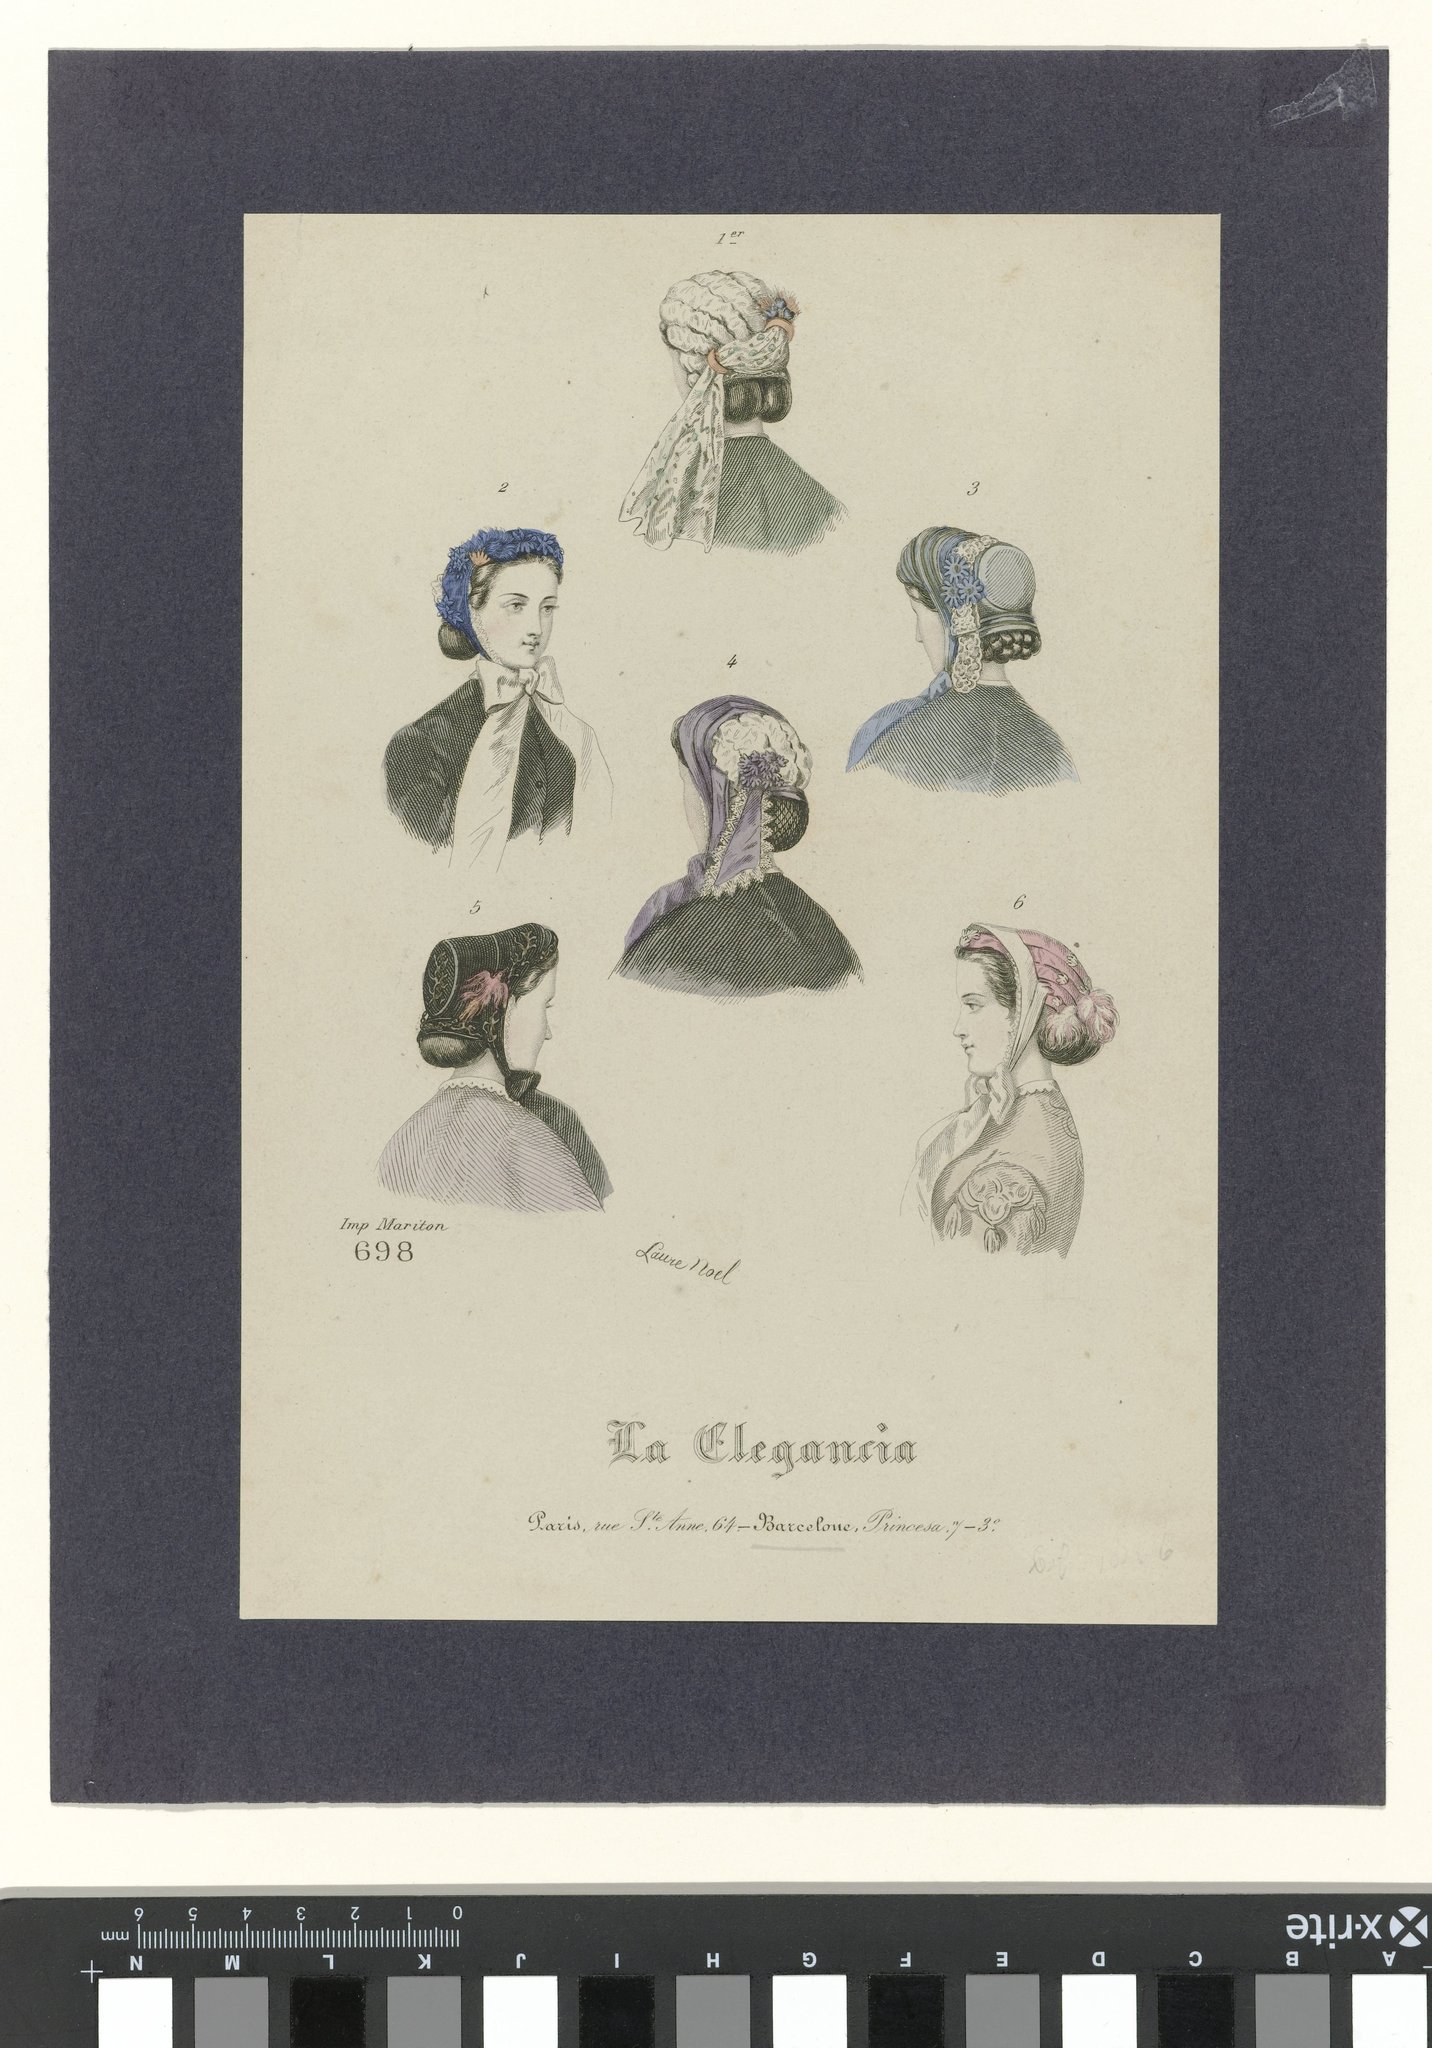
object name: fashion print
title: La Elegancia, 1854, No. 698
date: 1854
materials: paper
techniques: engraving, hand coloring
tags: head-gear: cap (+ women's clothes), fashion plates, head-gear: hat (+ women's clothes)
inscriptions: title: ‘La Elegancia’, address: ‘Paris, rue S.te Anne, 64 - Barcelone, Princesa, 7 - 3 .o’